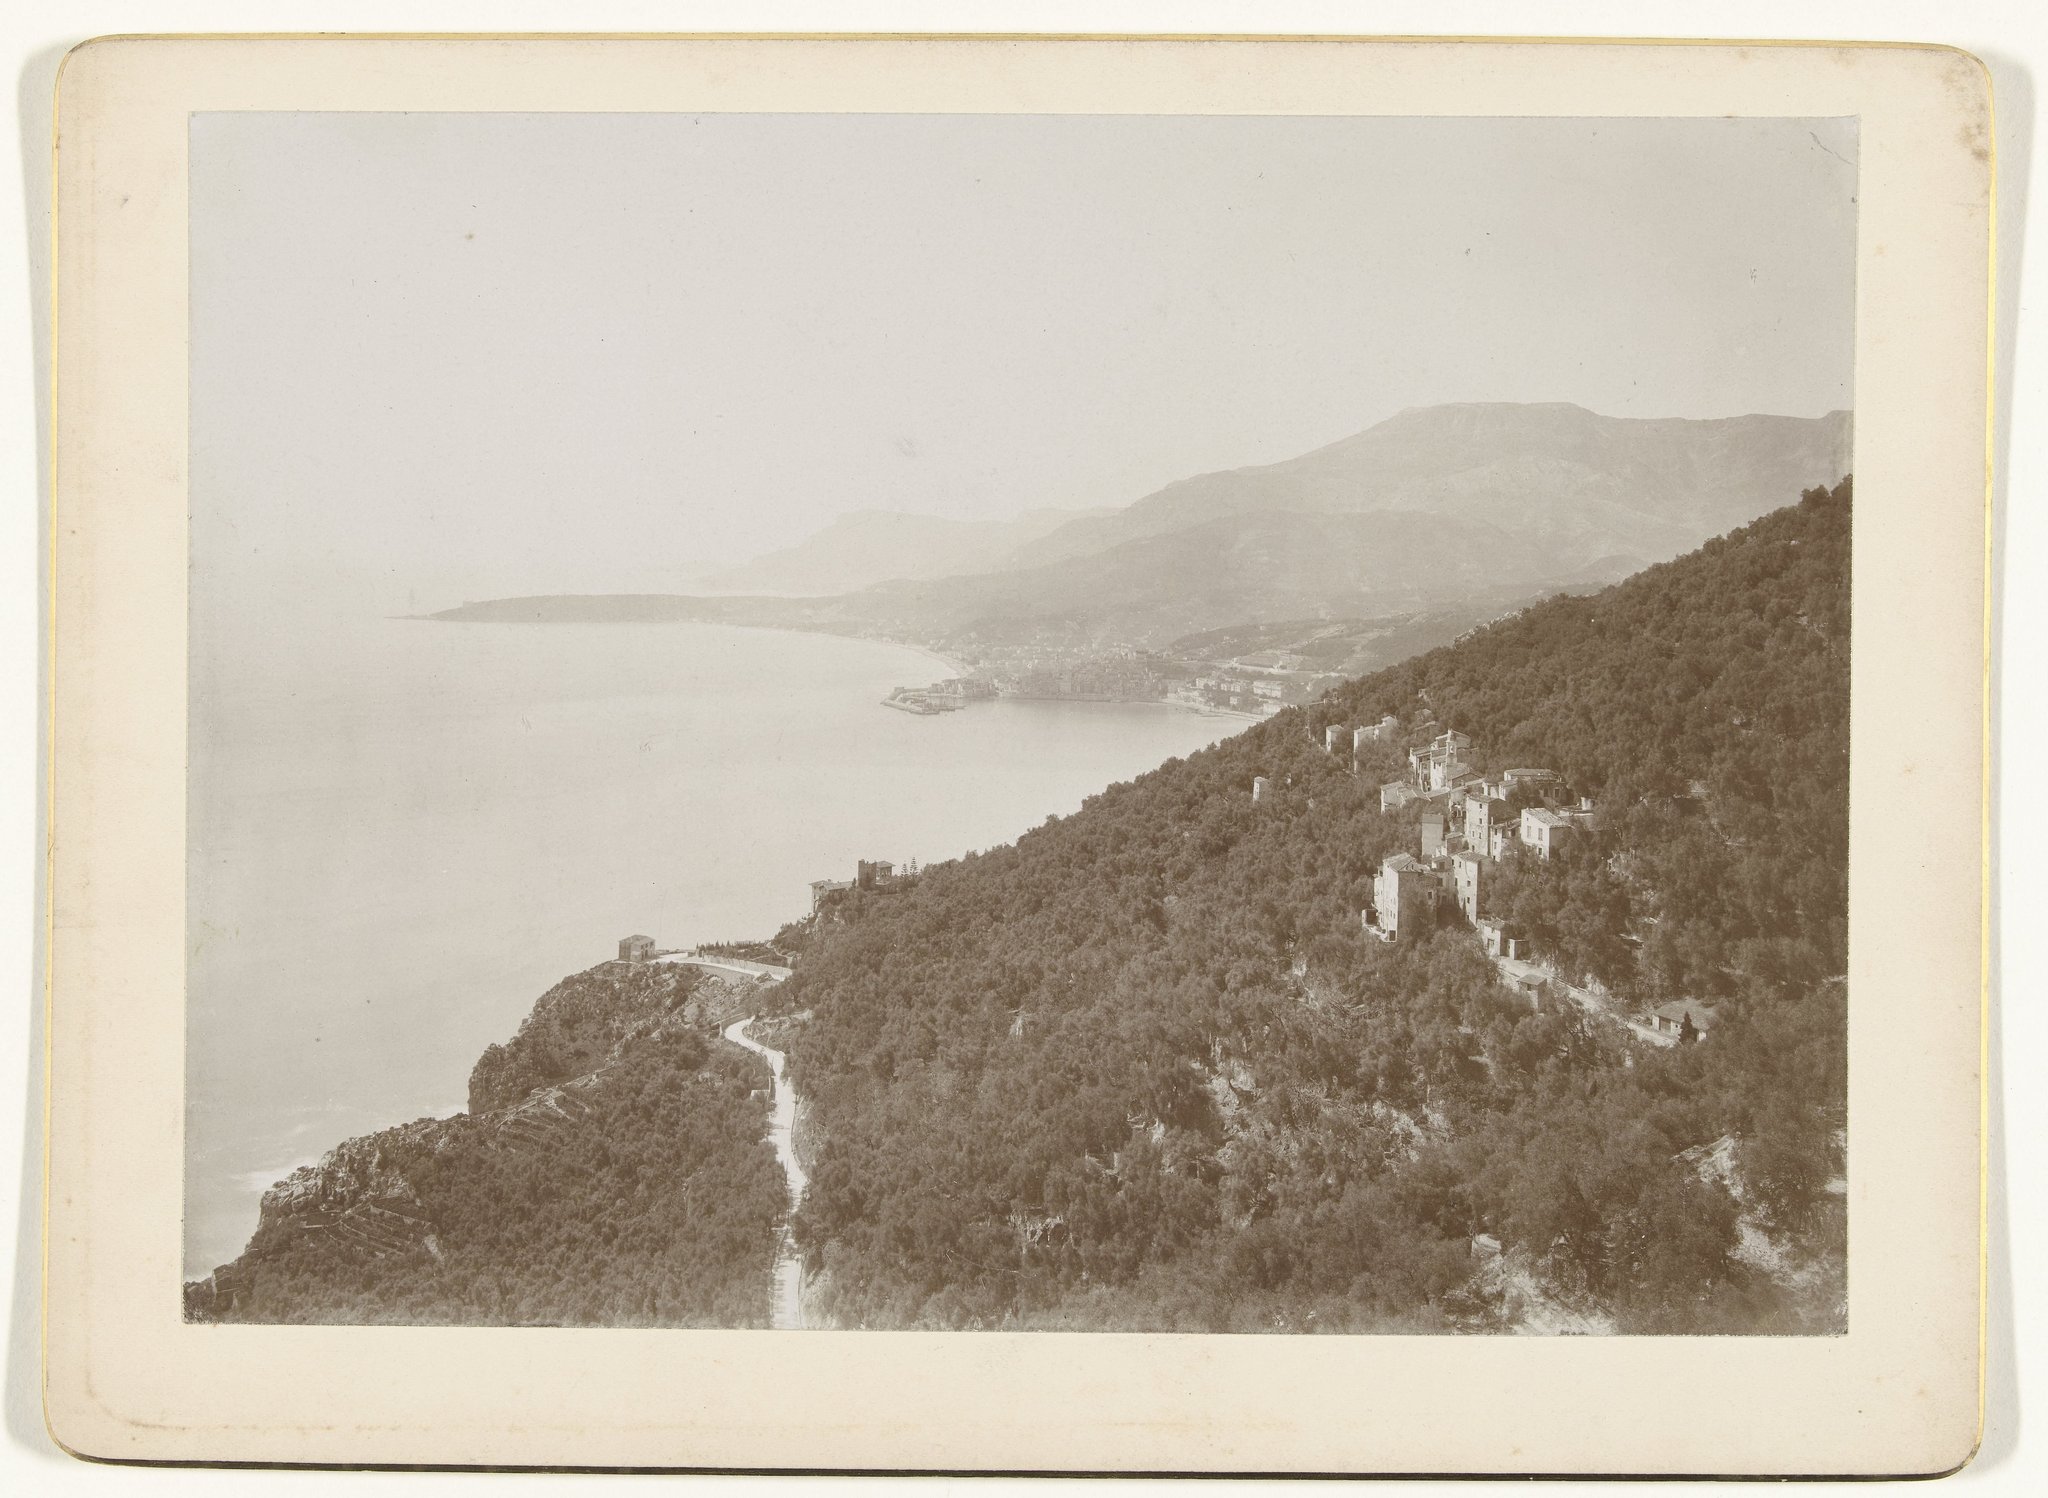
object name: photograph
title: Gezicht op Grimaldi (Italië) en Menton (Frankrijk)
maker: henry pauw van wieldrecht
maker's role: fotograaf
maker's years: 1863-1912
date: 1896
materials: cardboard, photographic support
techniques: gelatin silver print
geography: italy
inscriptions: annotation: ‘No. 1157. 1896.’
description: N.B.: Grimaldi is een plaats (frazione) in Ventimiglia Vgl. RP-F-2007-359-40